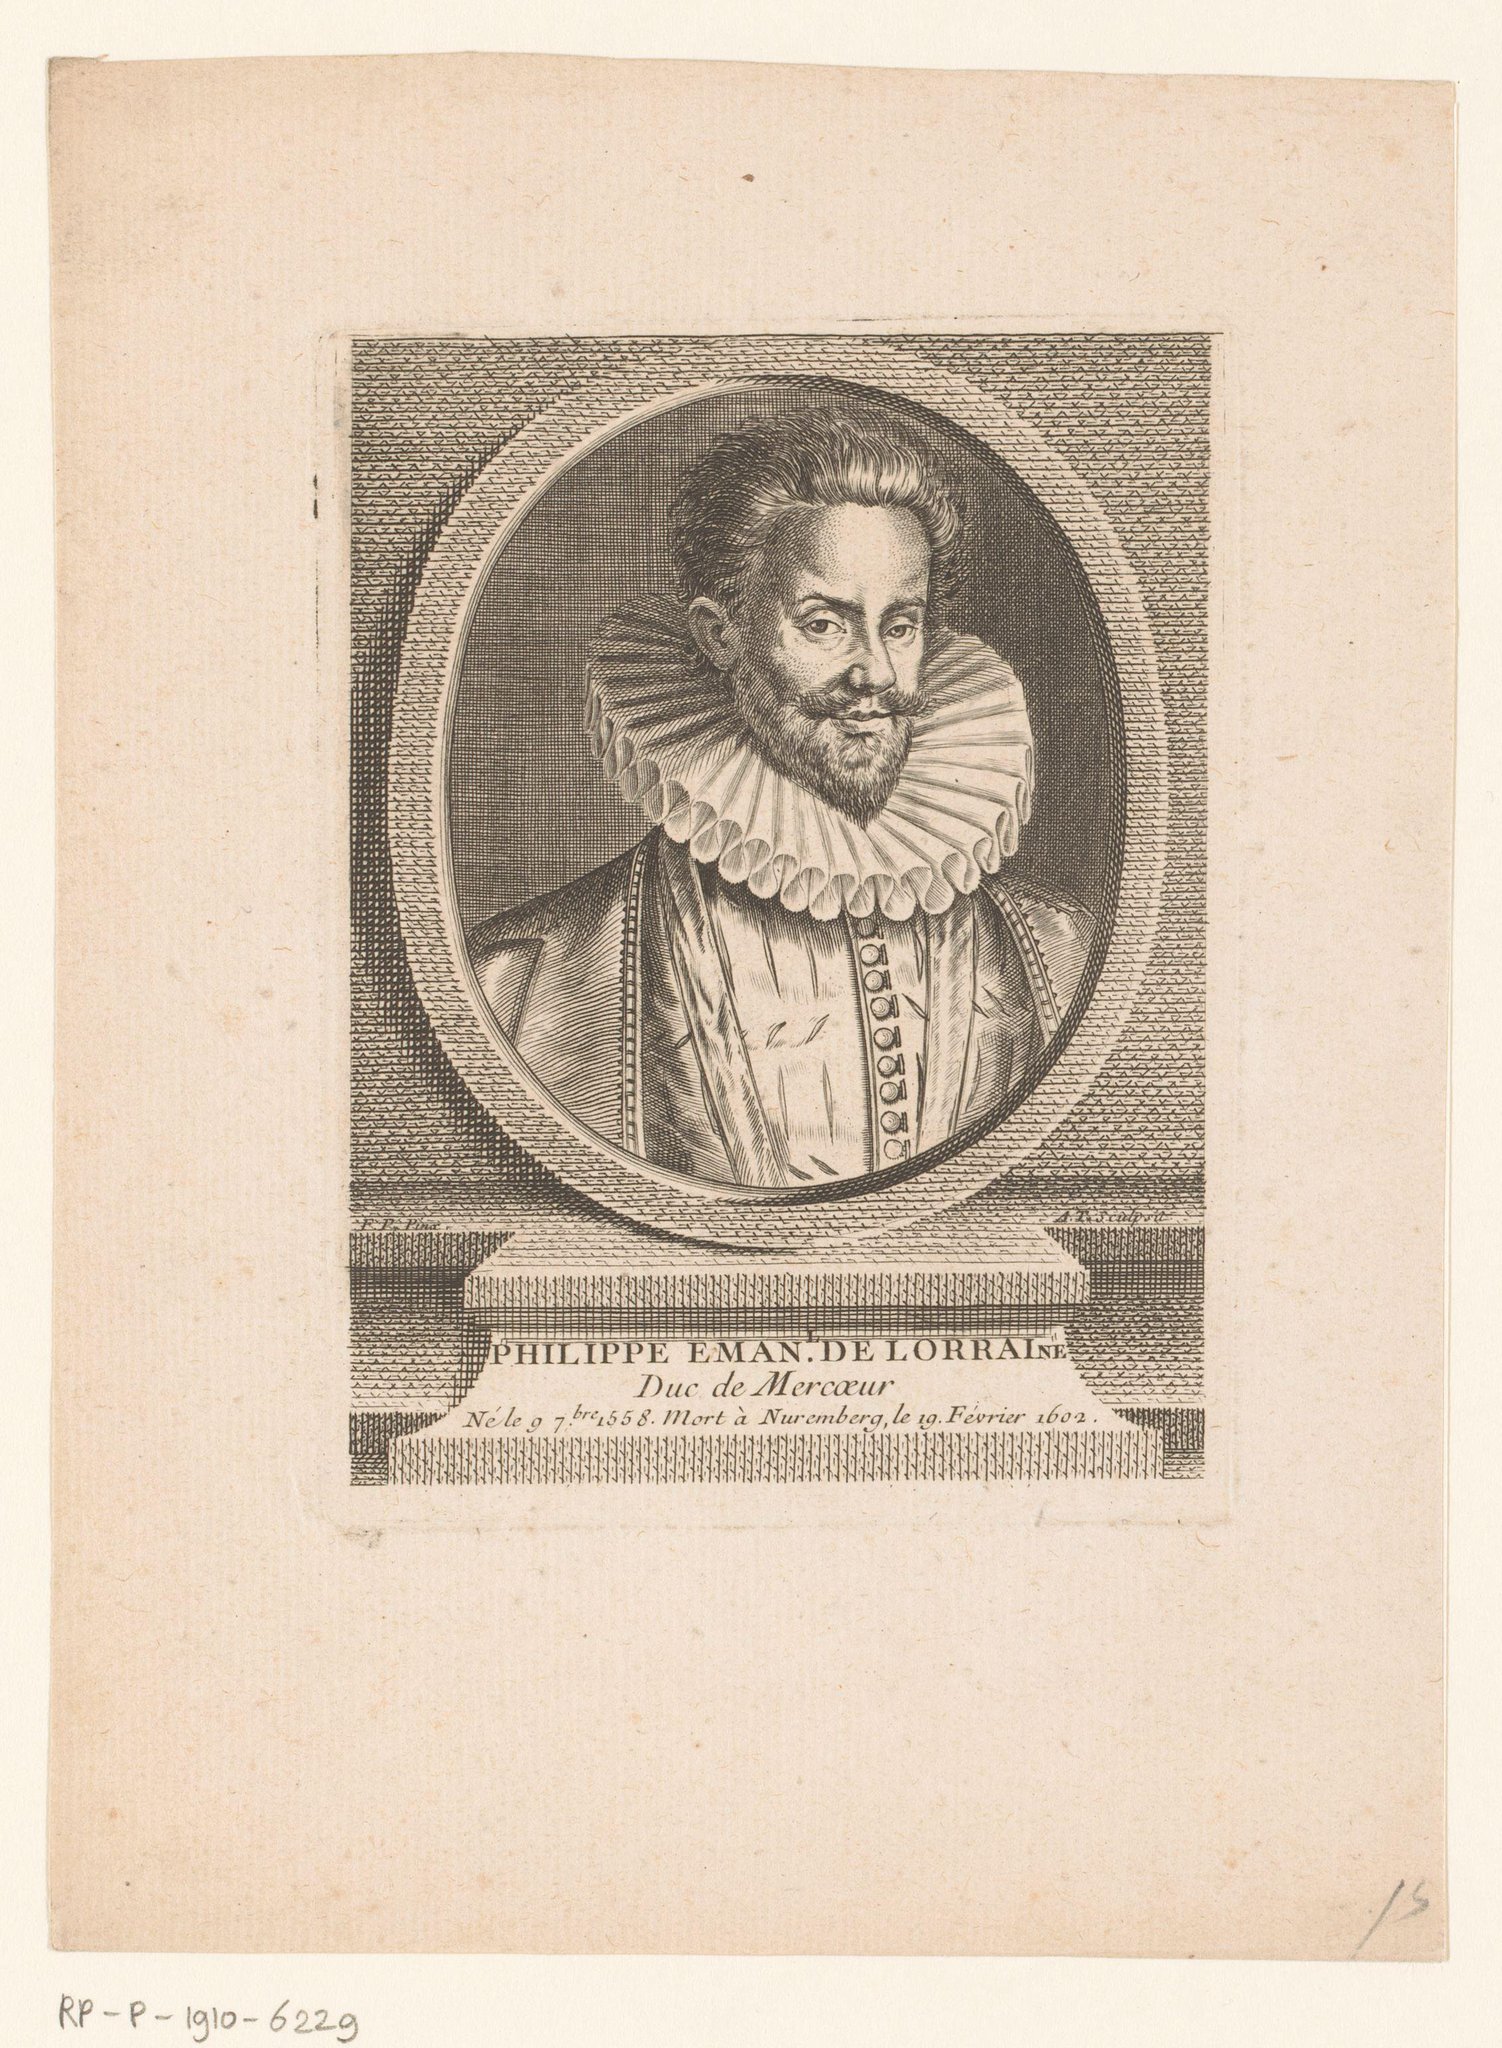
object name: print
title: Portret van Philippe-Emmanuel de Lorraine hertog van Mercoeur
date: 1700-1799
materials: paper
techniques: engraving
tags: historical persons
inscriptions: collector's mark: Lugt 2228